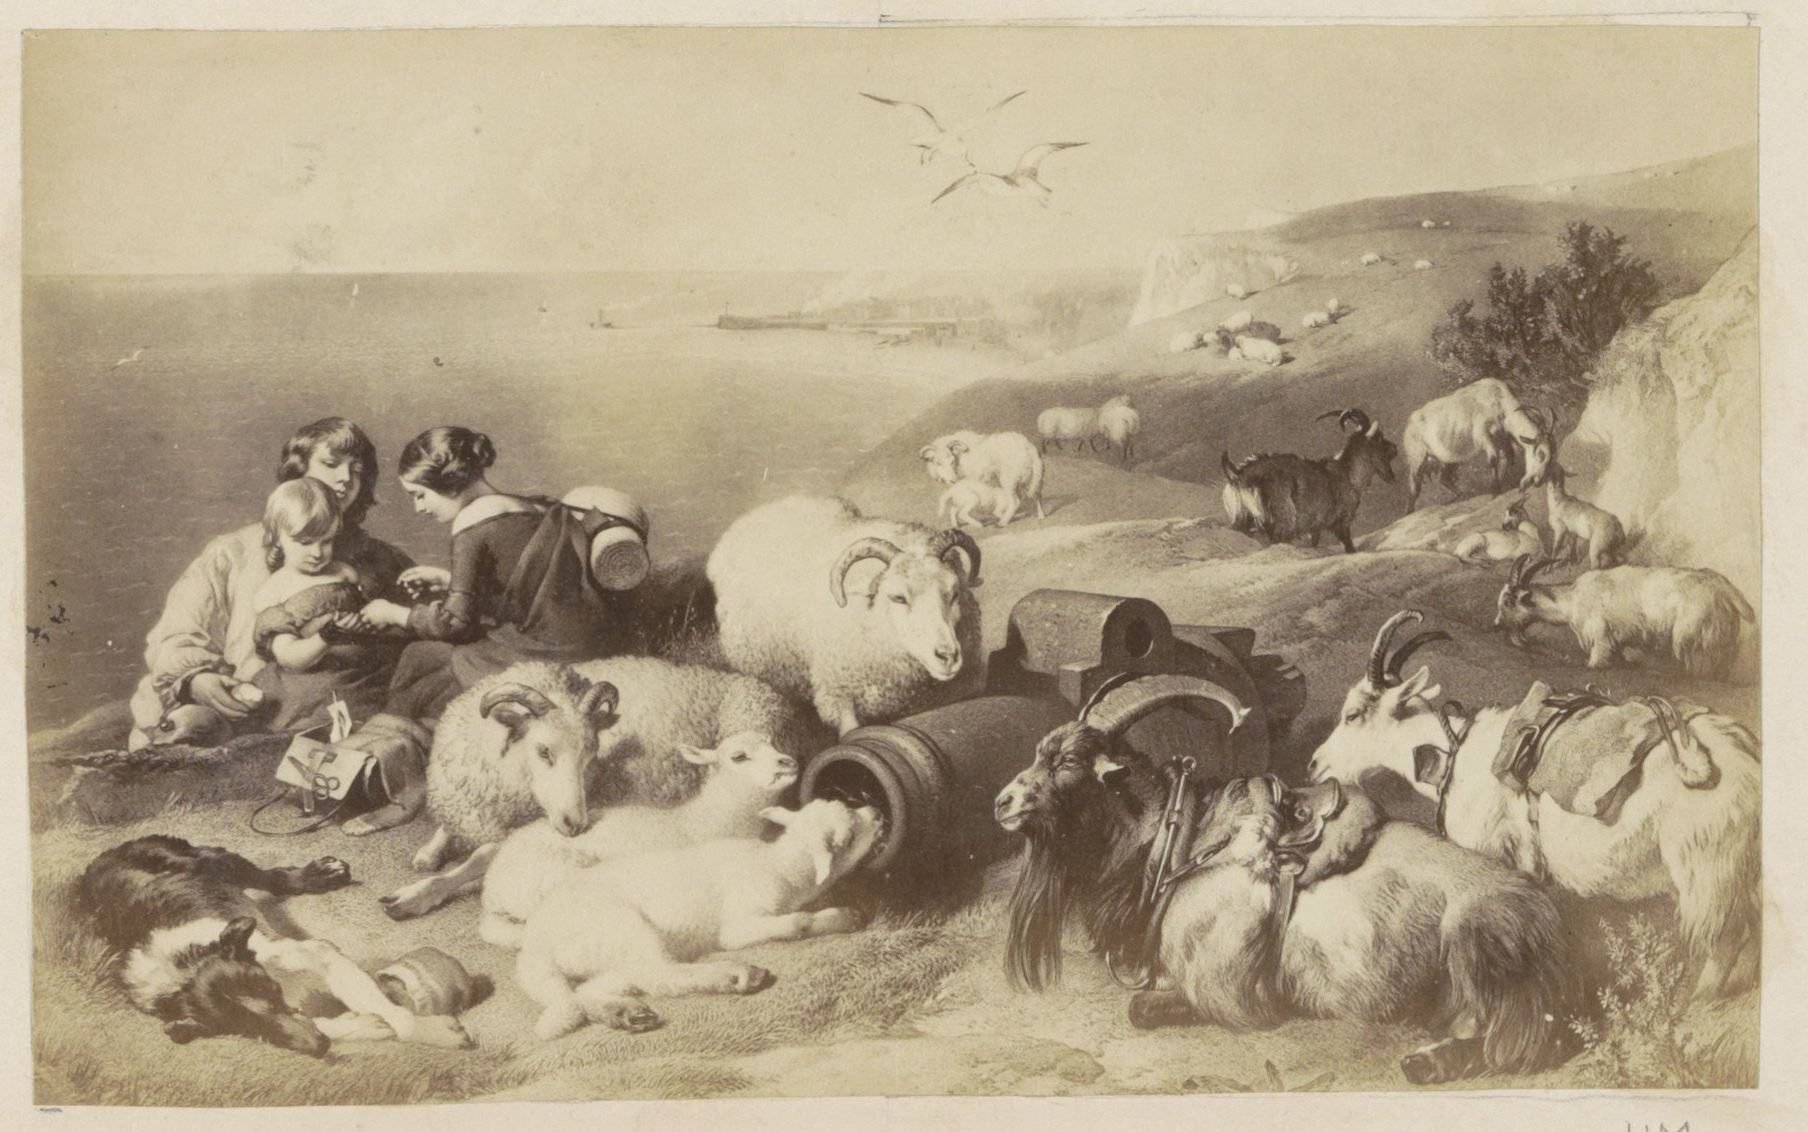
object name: photograph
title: Fotoreproductie van (vermoedelijk) een prent van een vrouw en twee kinderen bij een kudde geiten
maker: Anonymous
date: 1850-1870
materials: paper, photographic support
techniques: albumen print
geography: england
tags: goat, herd, flock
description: Onderdeel van Album met foto's van bezienswaardigheden en landschappen in Engeland en van kunst.